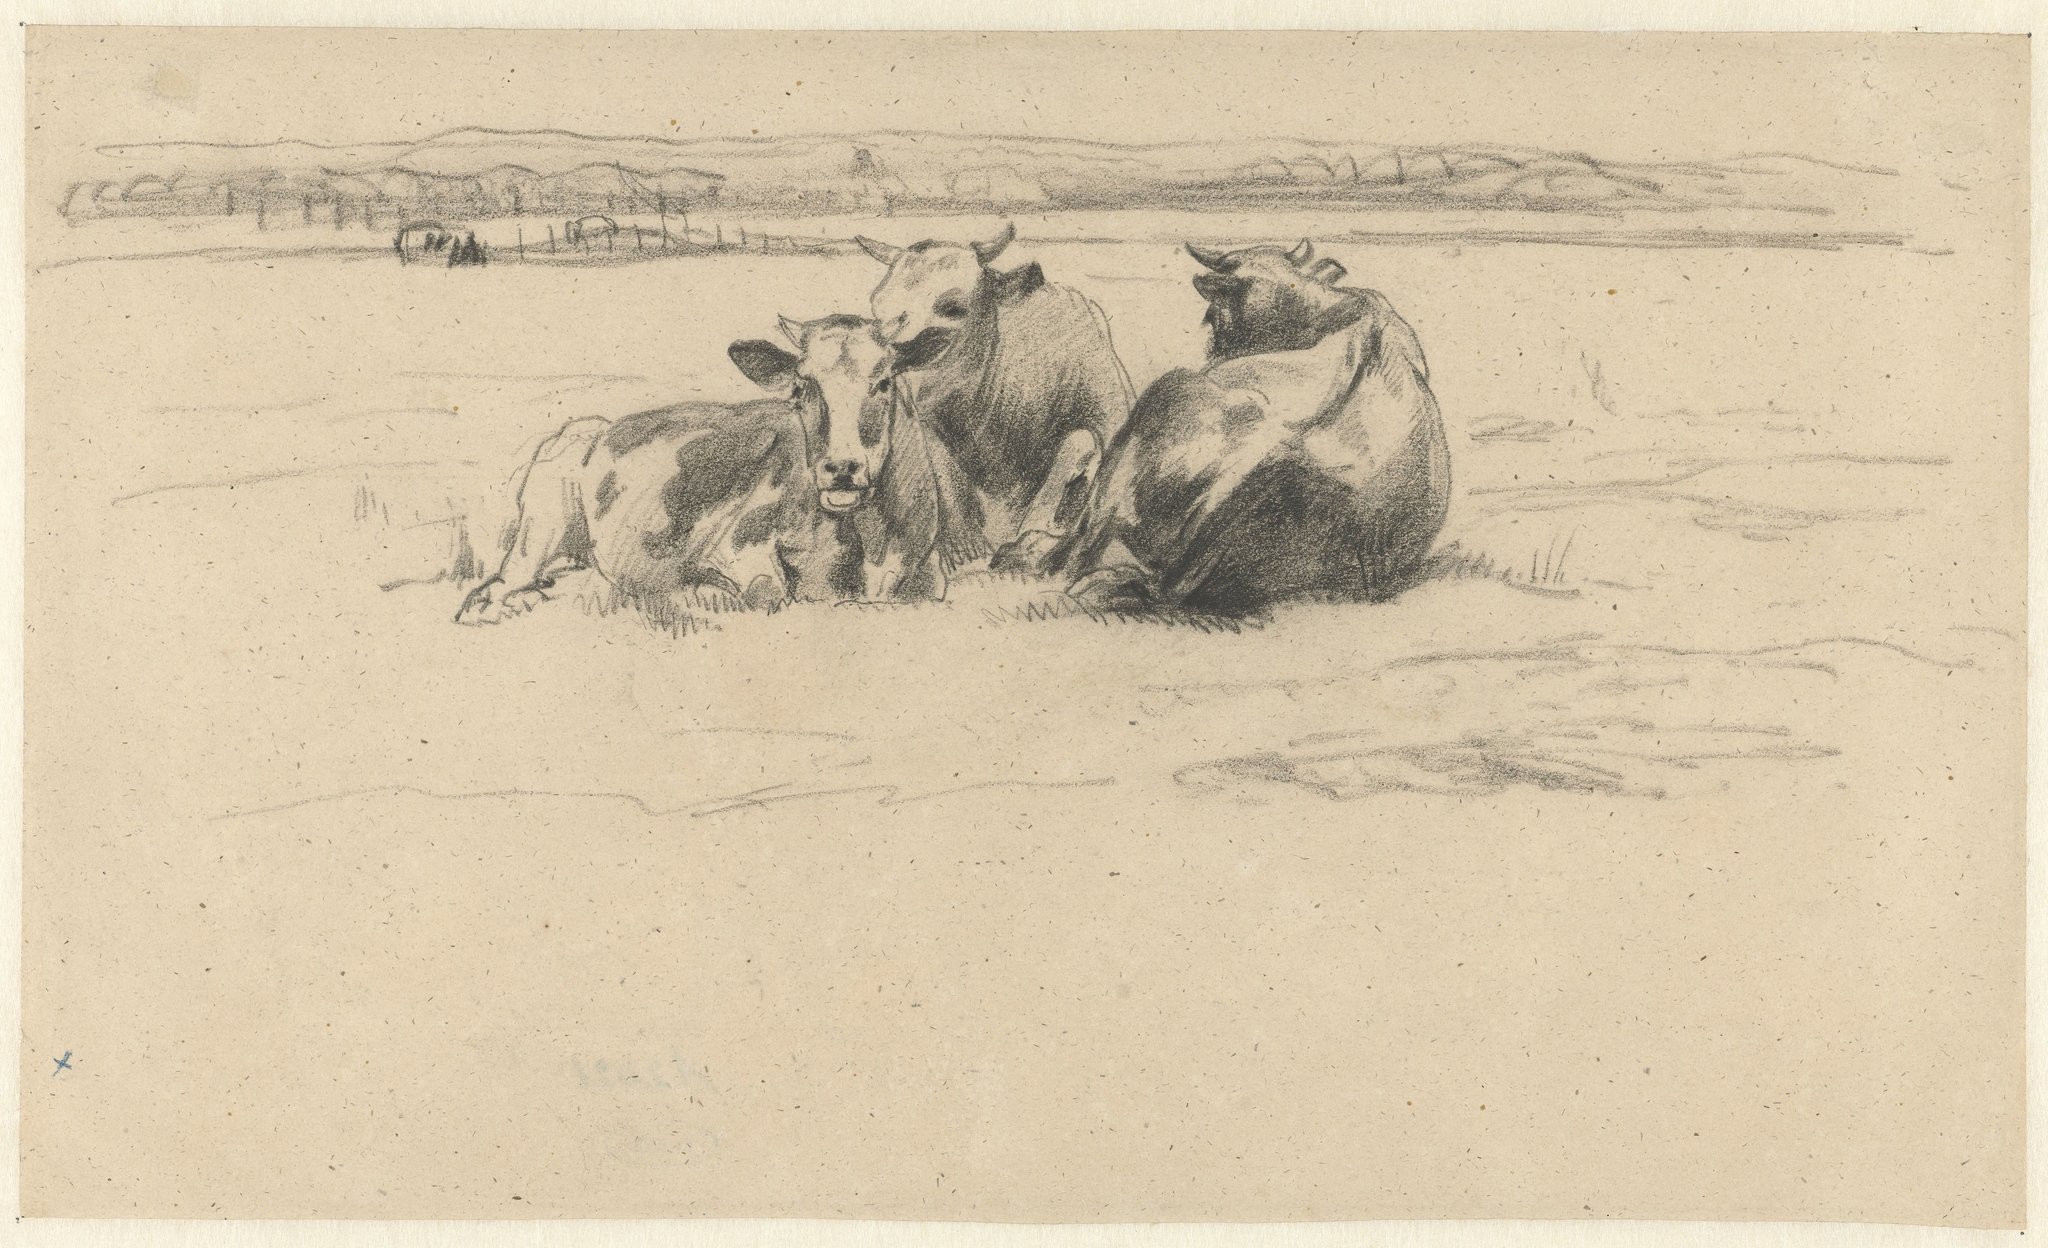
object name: drawing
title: Drie koeien bij elkaar liggend in een wei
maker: guillaume anne van der brugghen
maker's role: draughtsman, print maker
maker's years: 1812-1891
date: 1821-1889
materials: chalk, paper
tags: cow